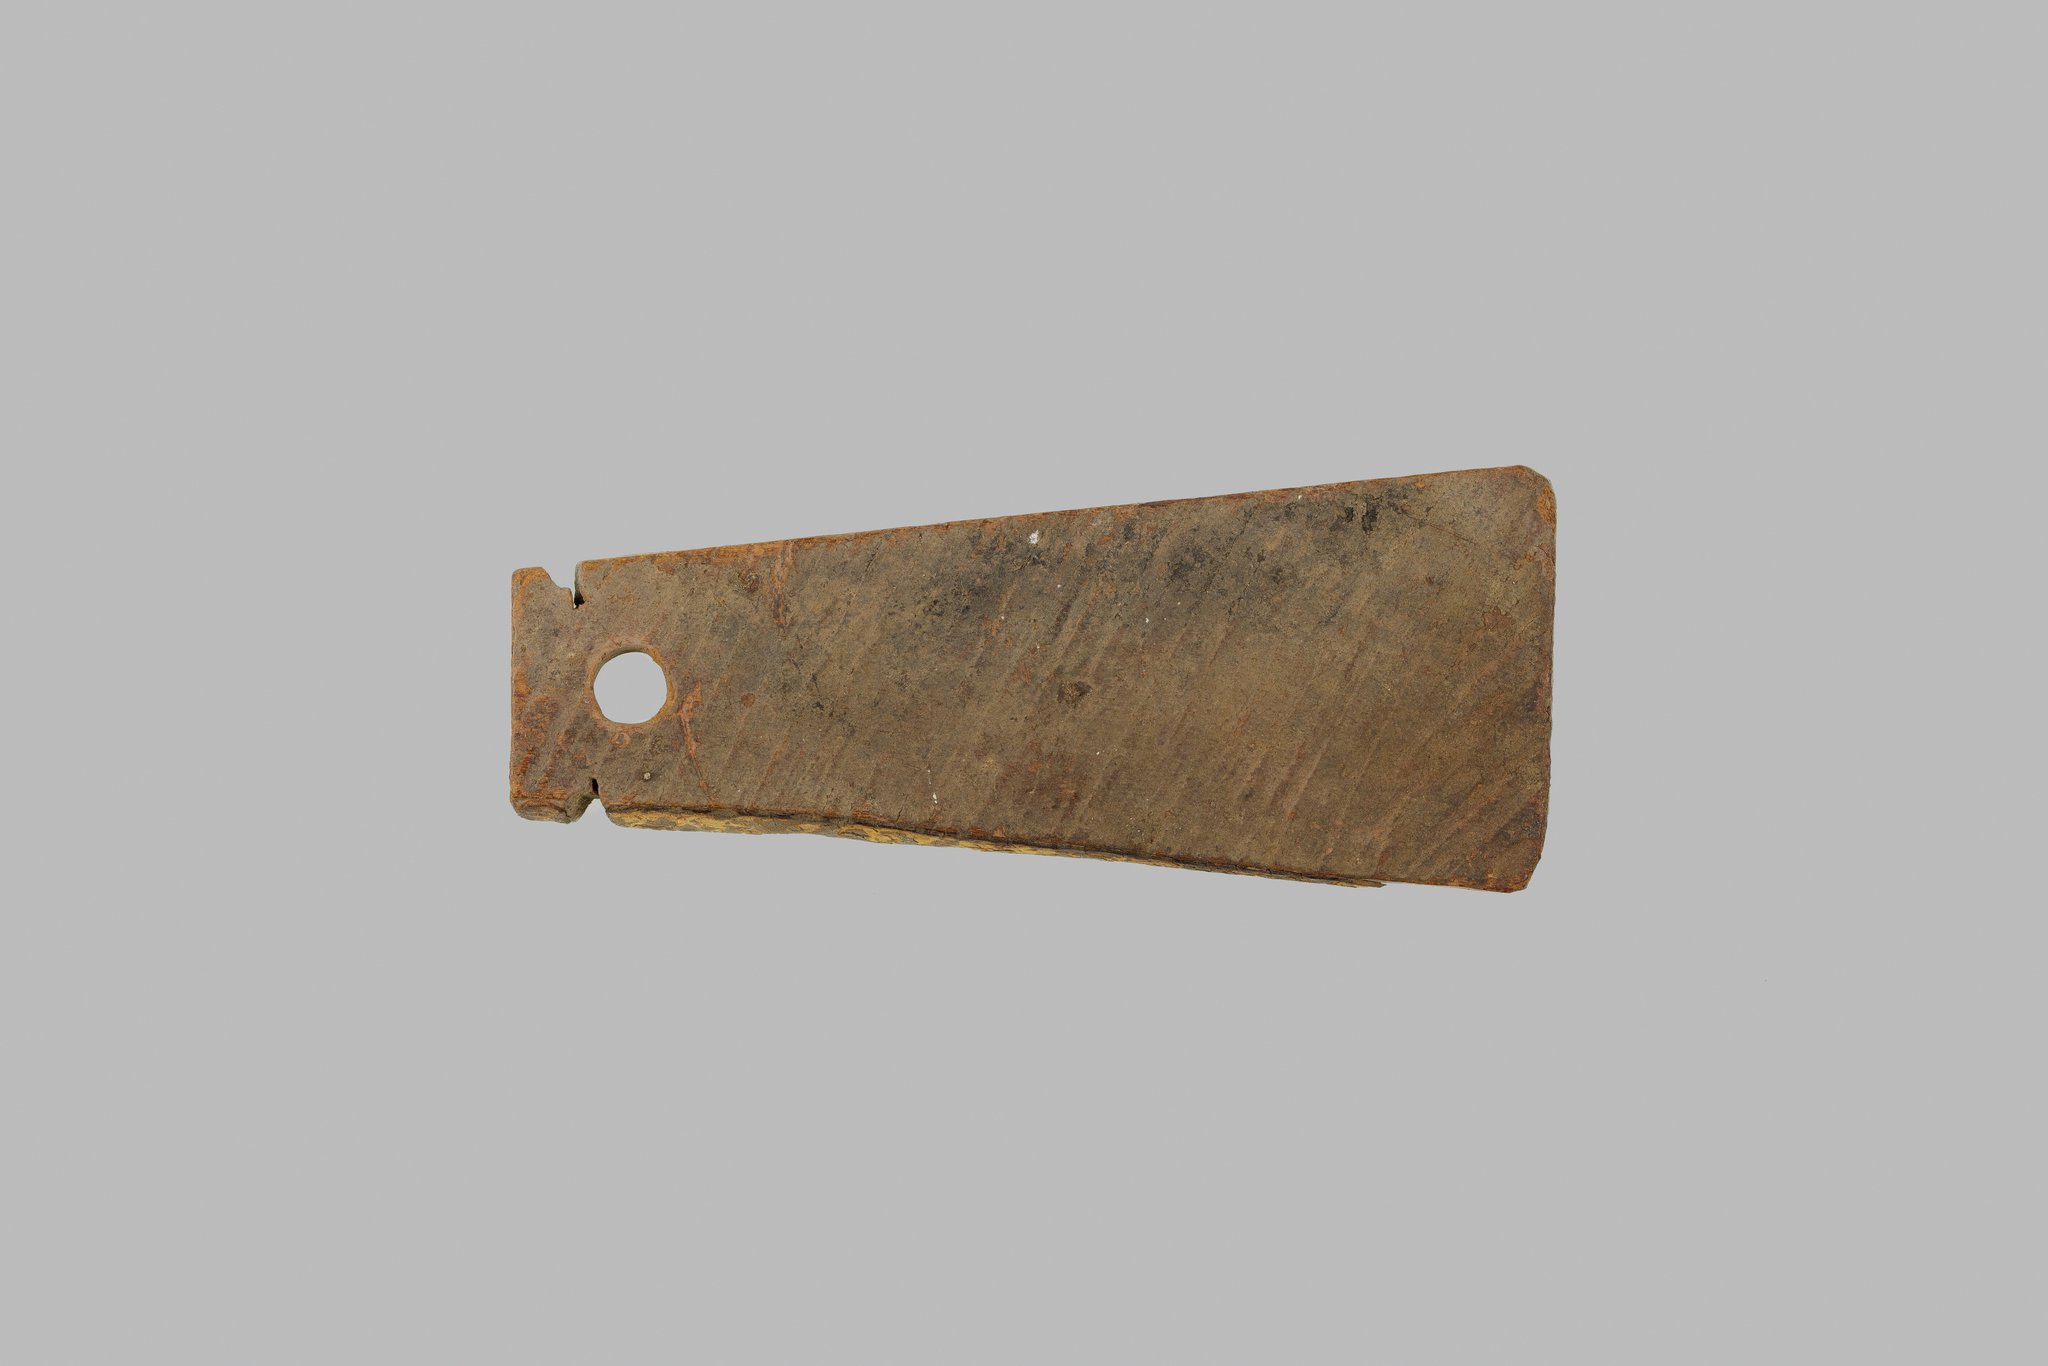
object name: mummy label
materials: wood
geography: egypt